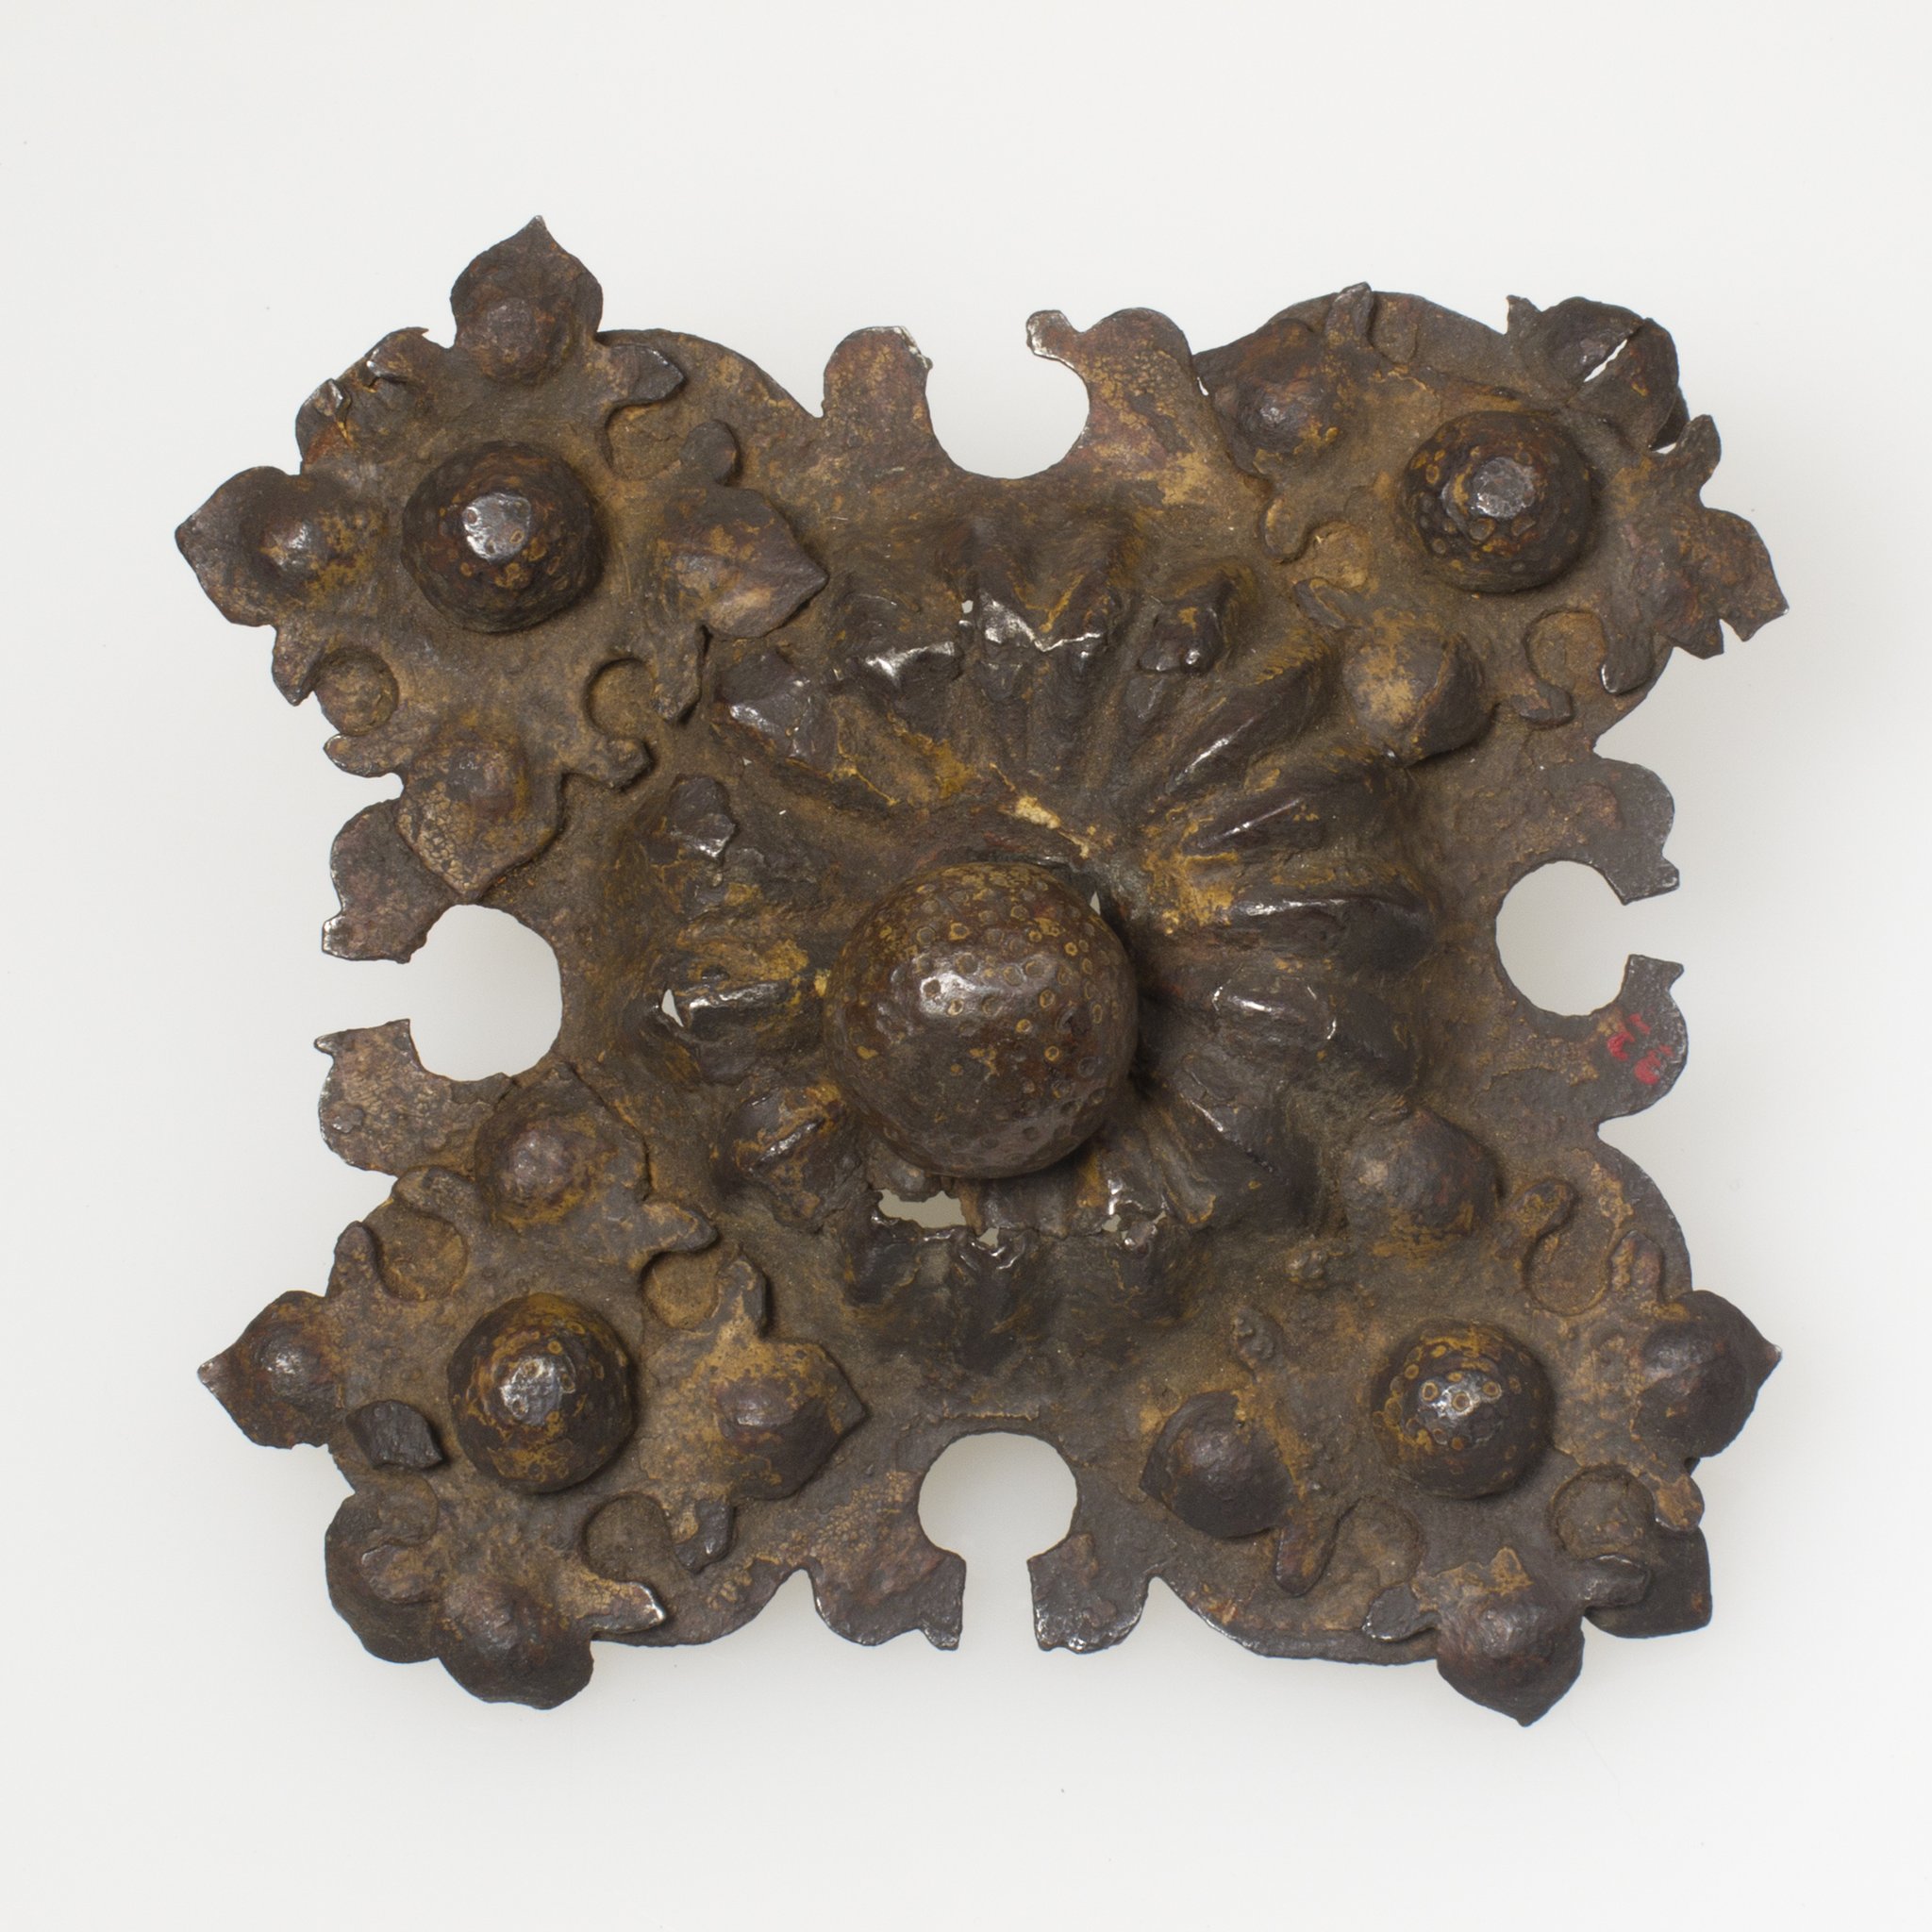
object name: bos and nail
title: Boss and Nail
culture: european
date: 1401-1600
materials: iron